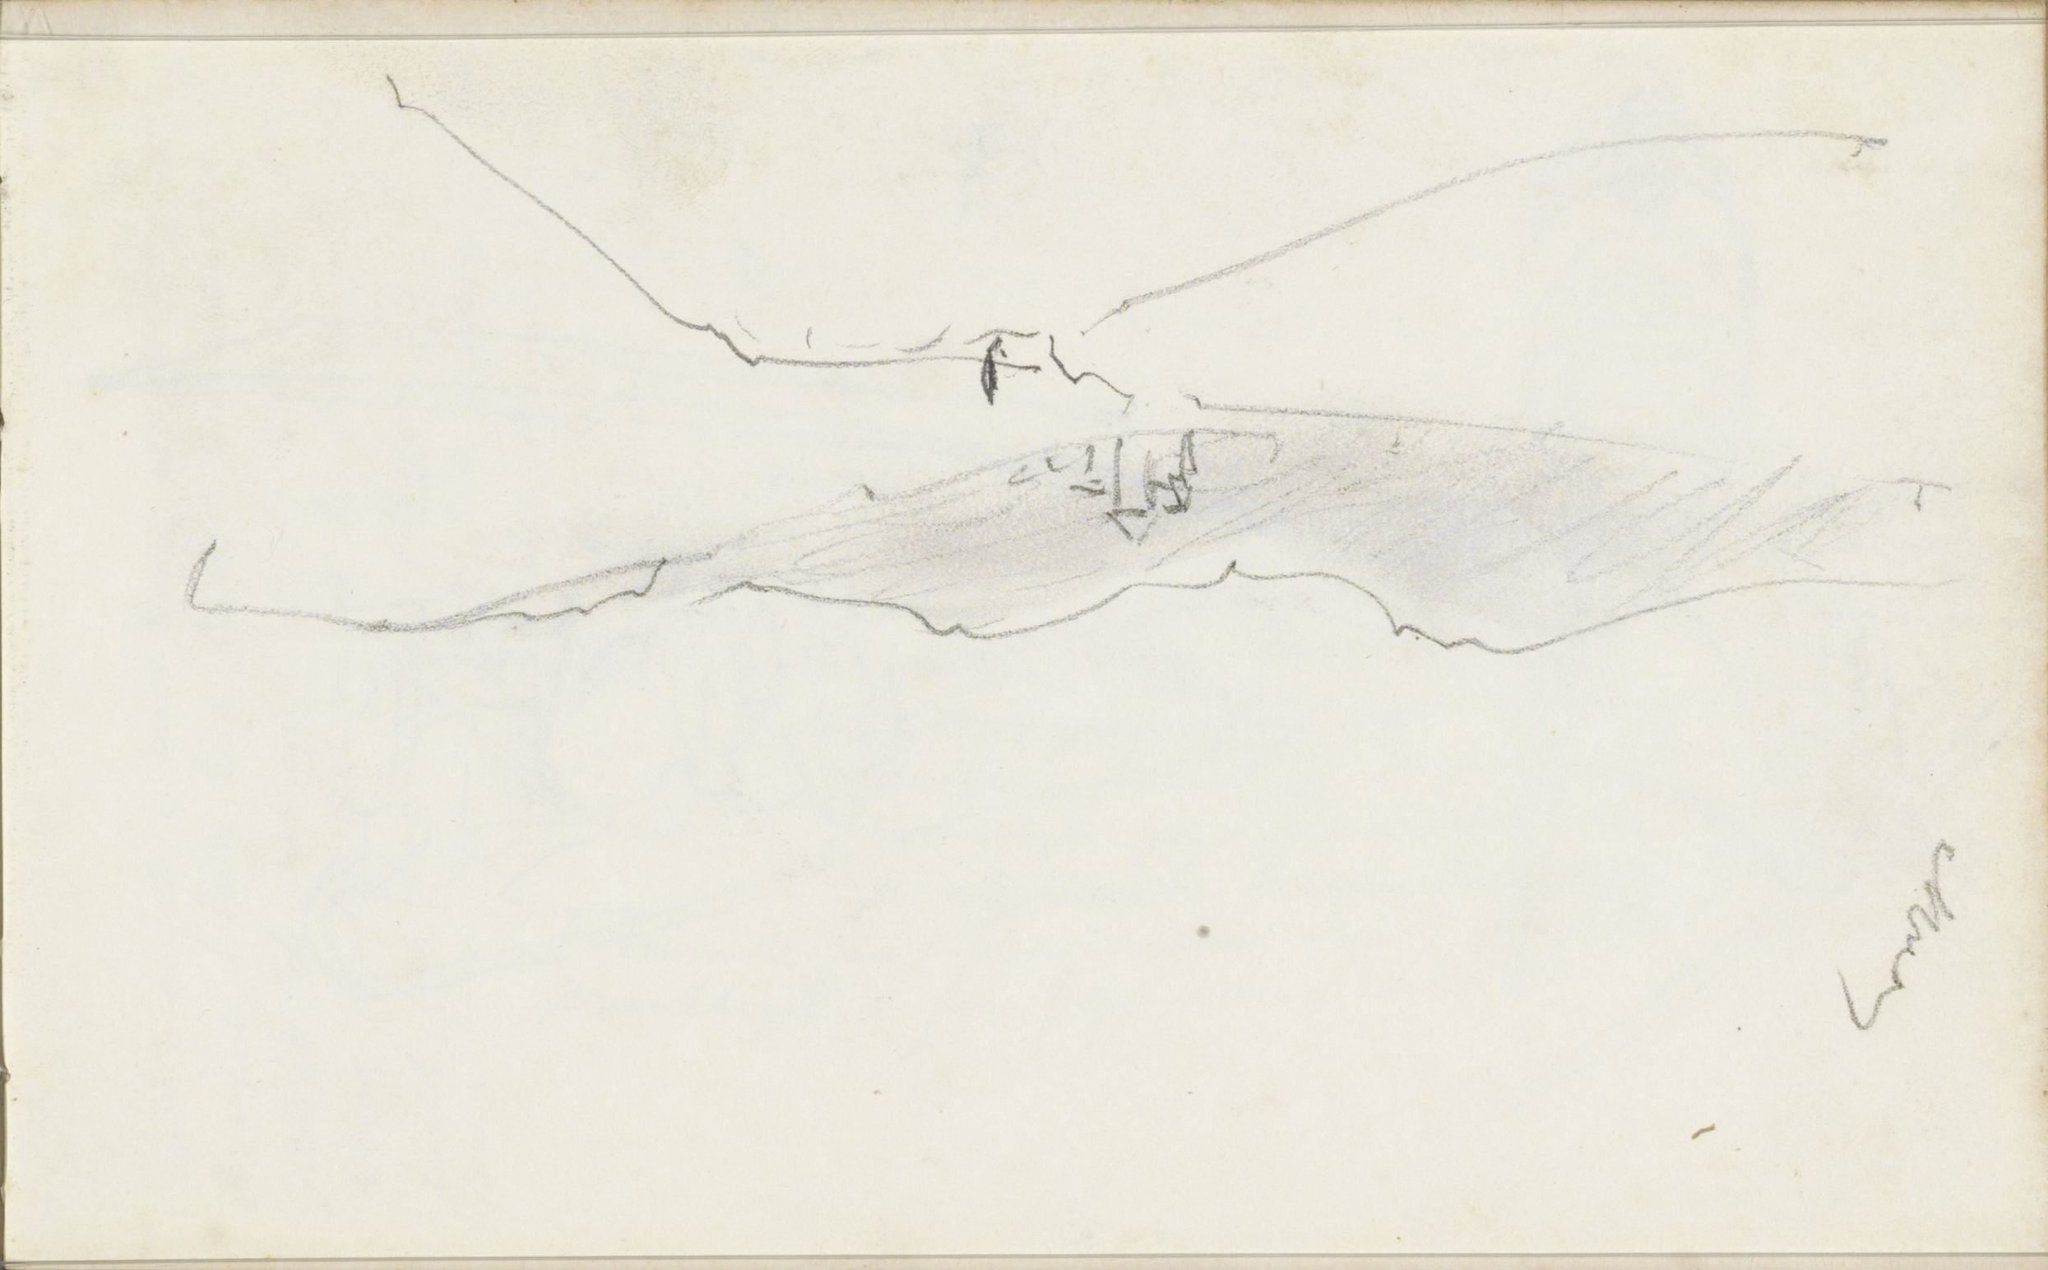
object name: sketchbook leaf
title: Heuvellandschap aan de Maas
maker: johannes tavenraat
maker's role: draughtsman, painter, print maker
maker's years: 1809-1881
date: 1840-1841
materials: paper, pencil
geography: meuse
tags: city-view, and landscape with man-made constructions, low hill country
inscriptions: annotation: ‘Maas’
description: Blad 29 recto uit een schetsboek met 41 bladen.